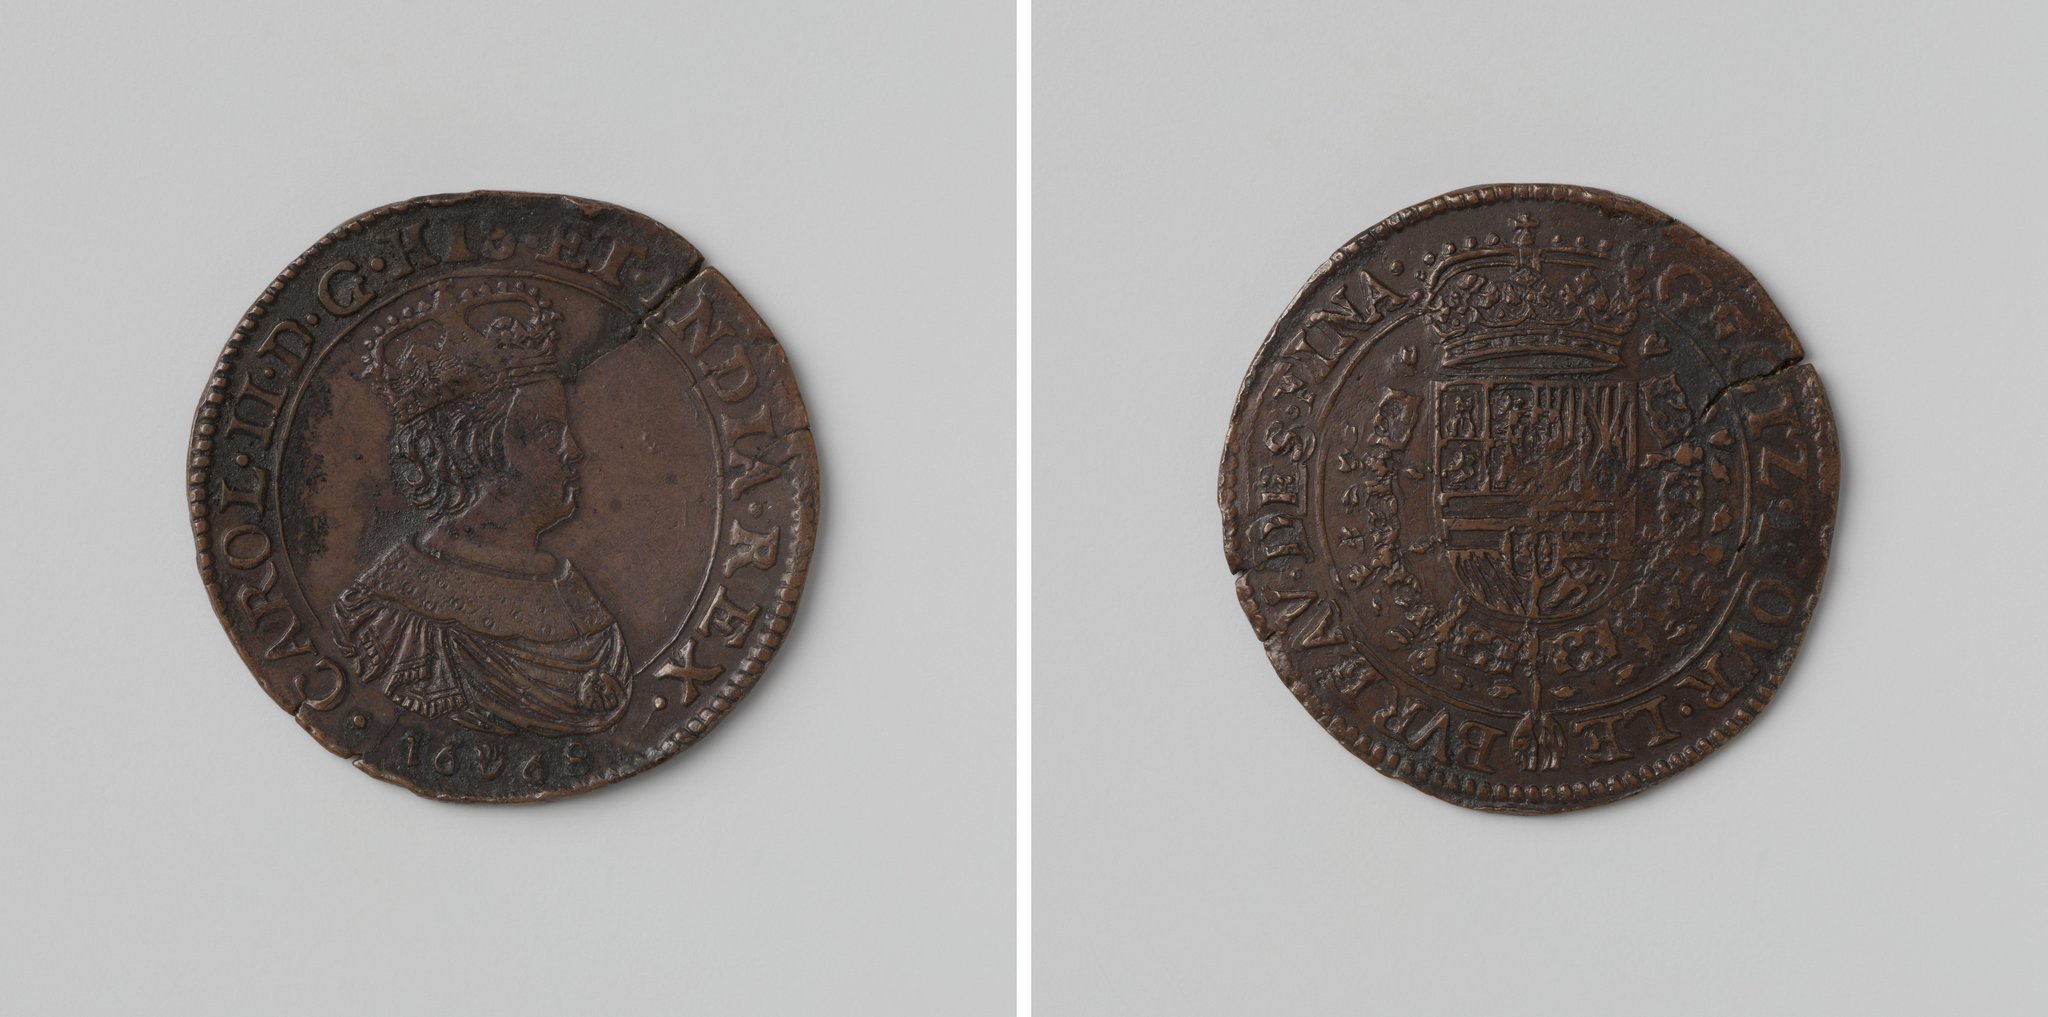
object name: jeton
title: Karel II, koning van Spanje, rekenpenning geslagen op last van de raad van Financiën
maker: Anonymous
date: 1668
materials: copper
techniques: striking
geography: antwerp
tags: karel ii (koning van spanje)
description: Koperen penning. Voorzijde: borststuk man met kroon binnen omschrift. Keerzijde: gekroond wapenschild, omhangen met de orde van het Gulden Vlies binnen omschrift